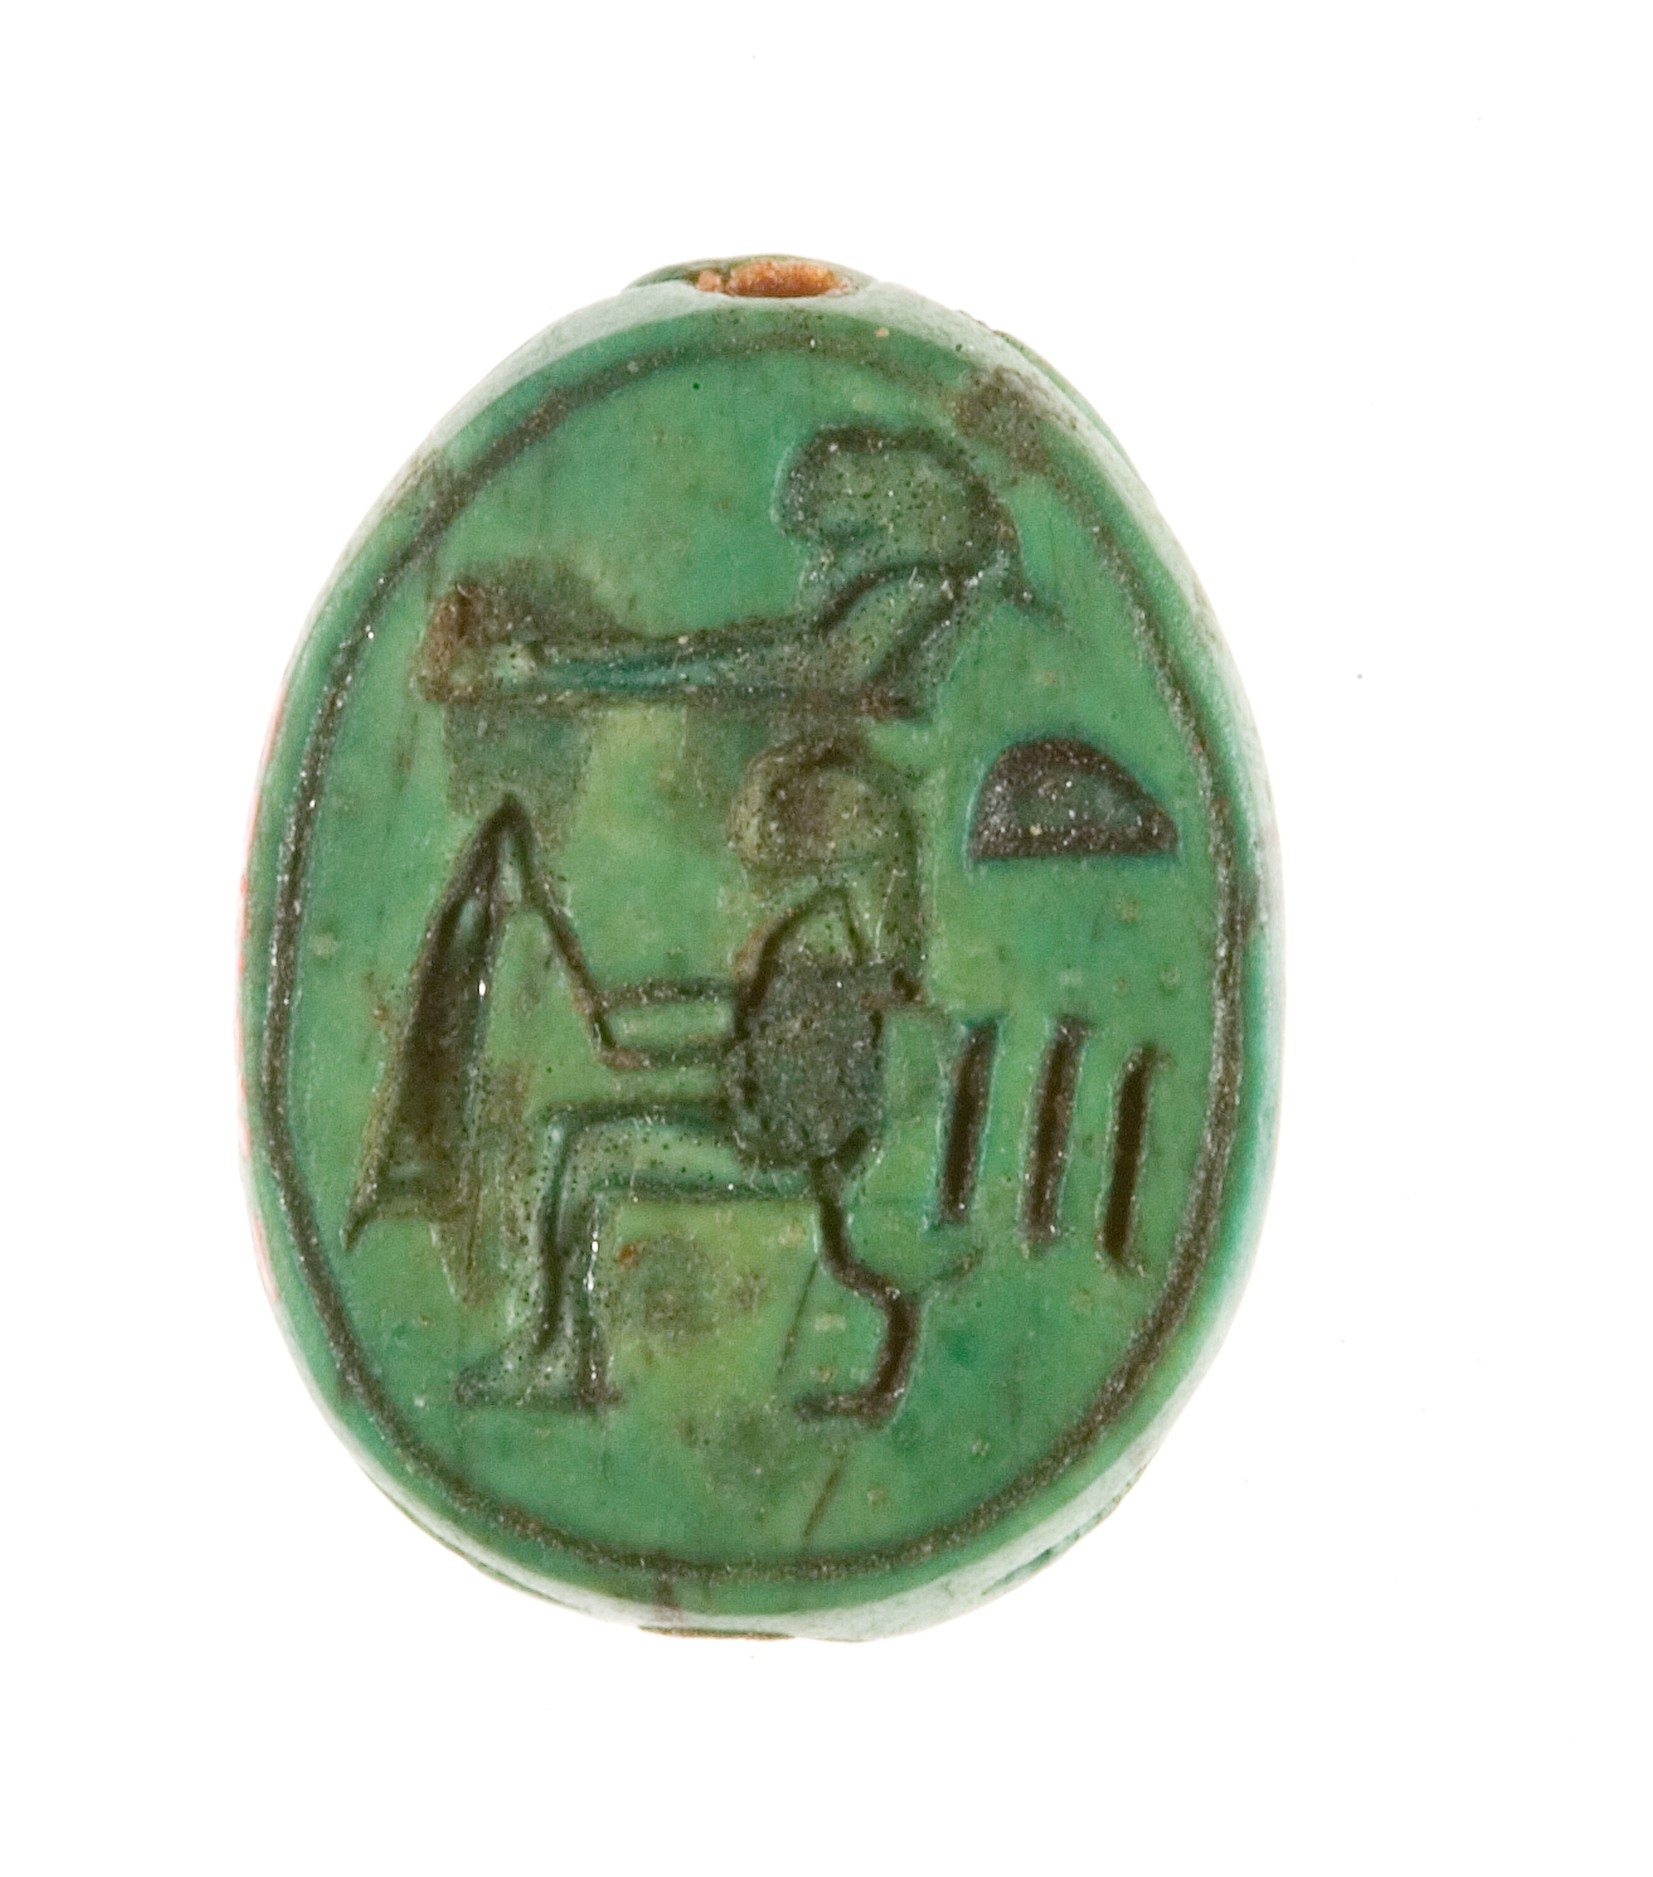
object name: scarab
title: Scarab Inscribed for Hatshepsut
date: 1479-1458 BCE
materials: stone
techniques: glazing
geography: egypt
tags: scarabs